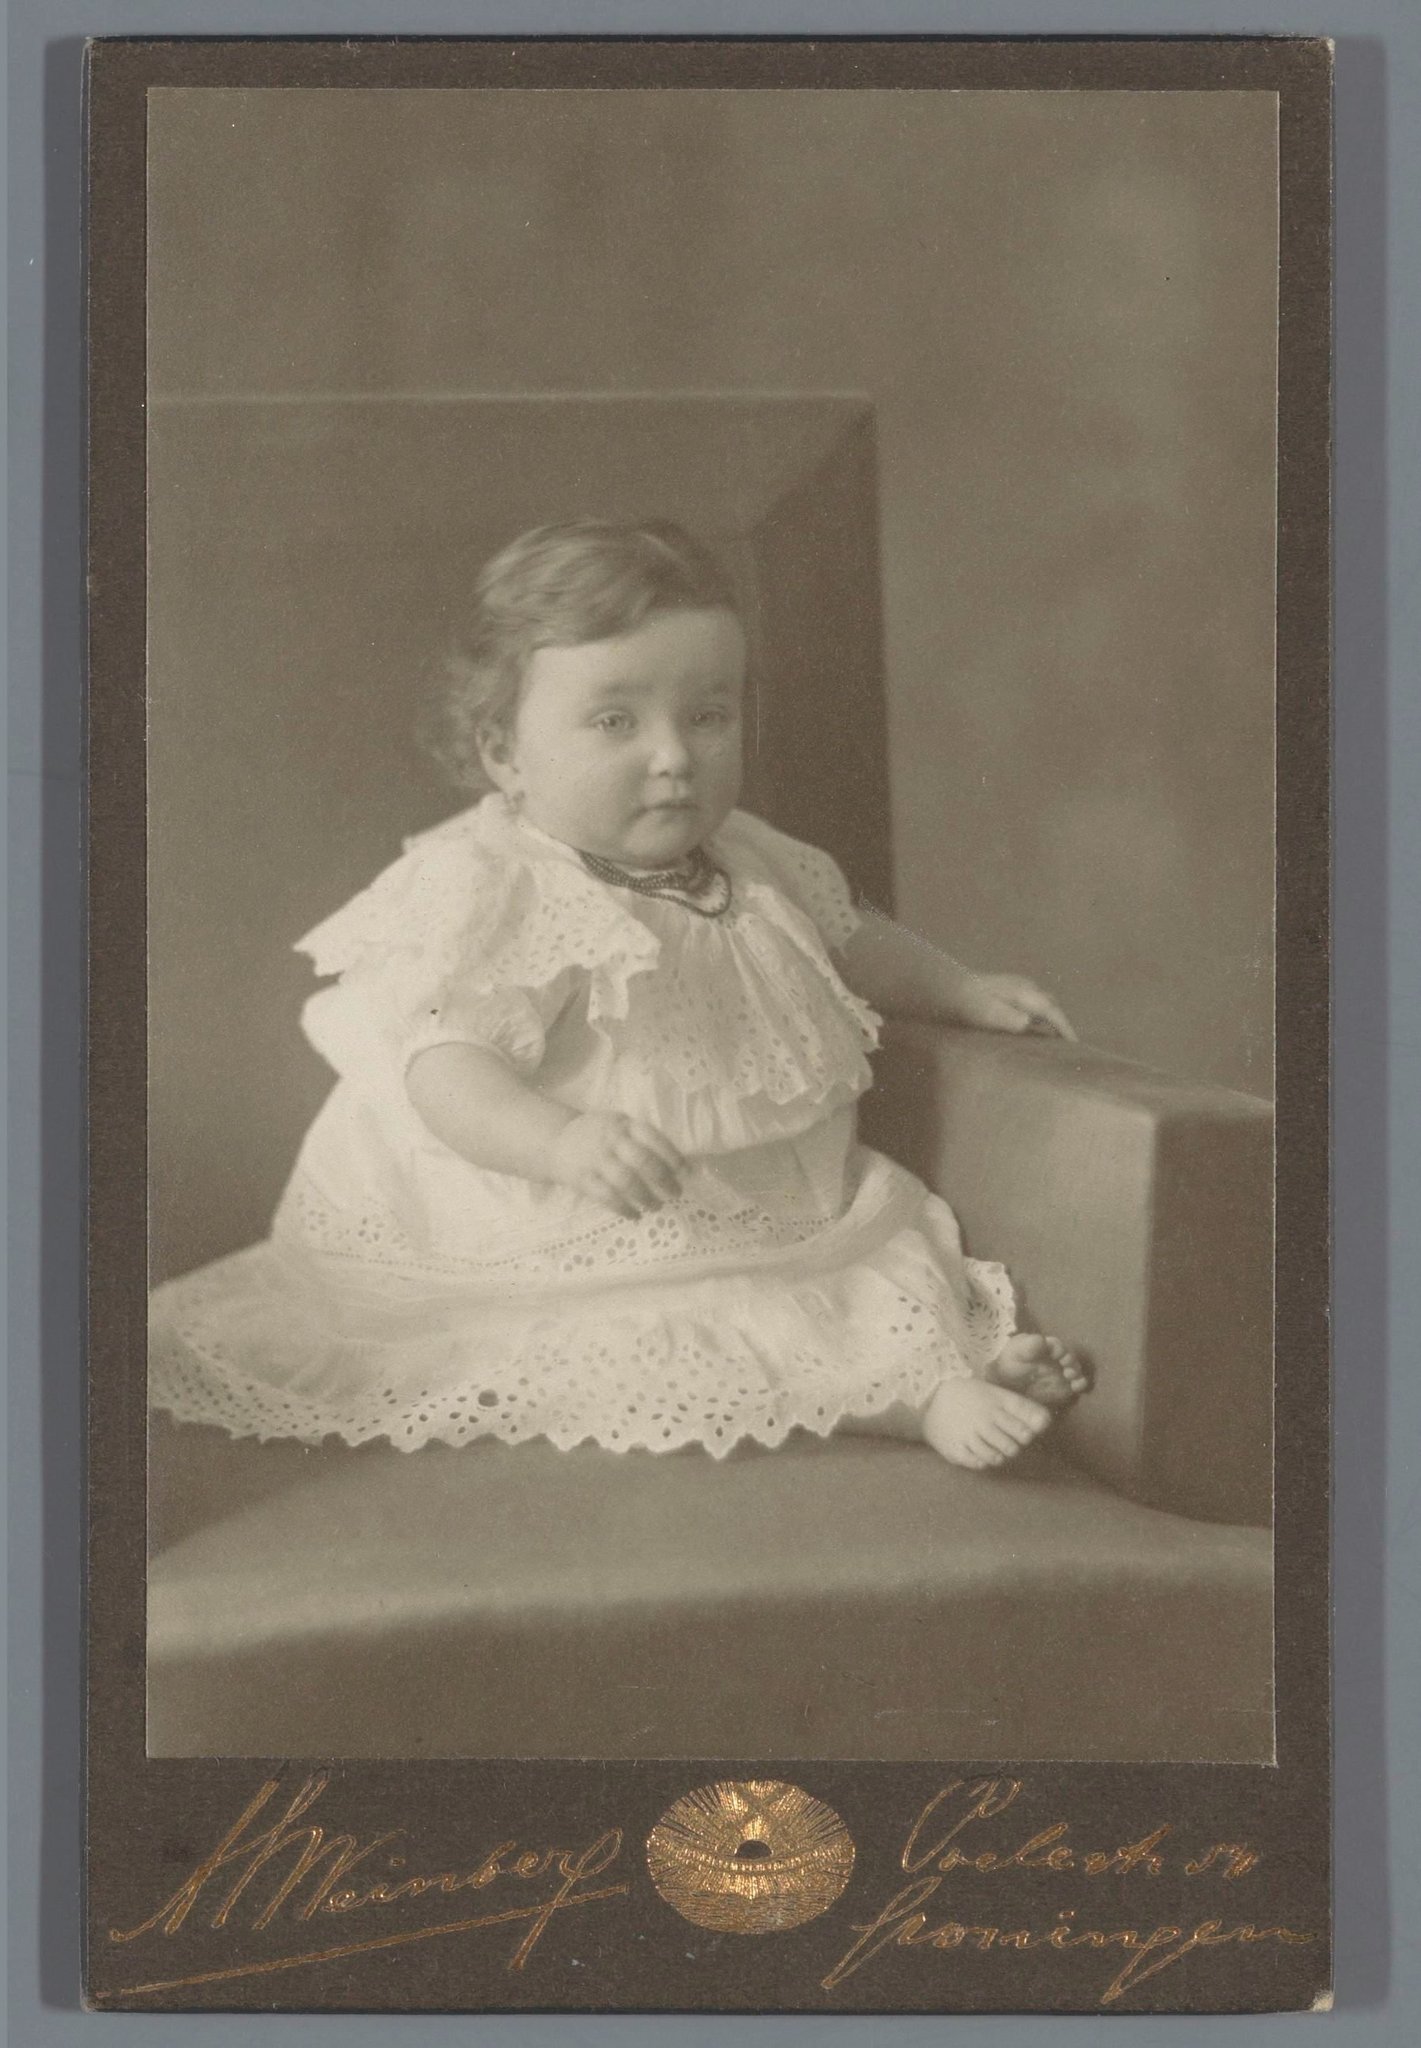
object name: carte de visite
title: Portret van een onbekend kind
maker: abraham salomon weinberg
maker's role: fotograaf, hofleverancier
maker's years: 1869-1932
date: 1907-1933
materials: paper, cardboard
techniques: gelatin silver print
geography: groningen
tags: child, anonymous historical person portrayed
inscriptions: inscription: ‘AWeinberg/ Poelestr 50/ Groningen’